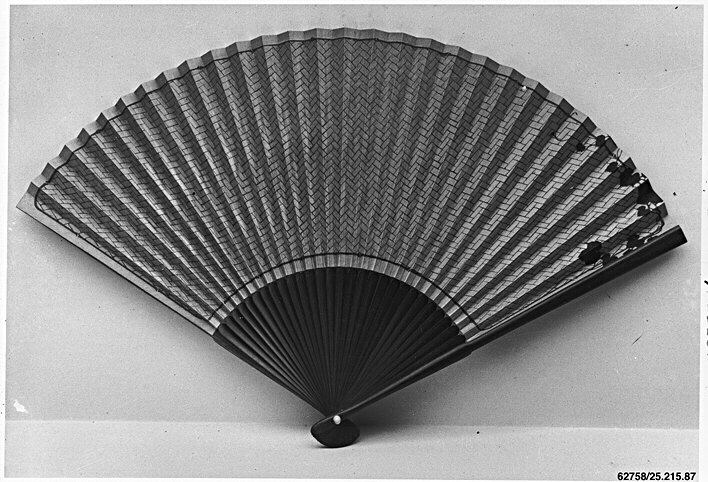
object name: folding fan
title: Fan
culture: japanese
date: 1901-2000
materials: metal, paint, paper